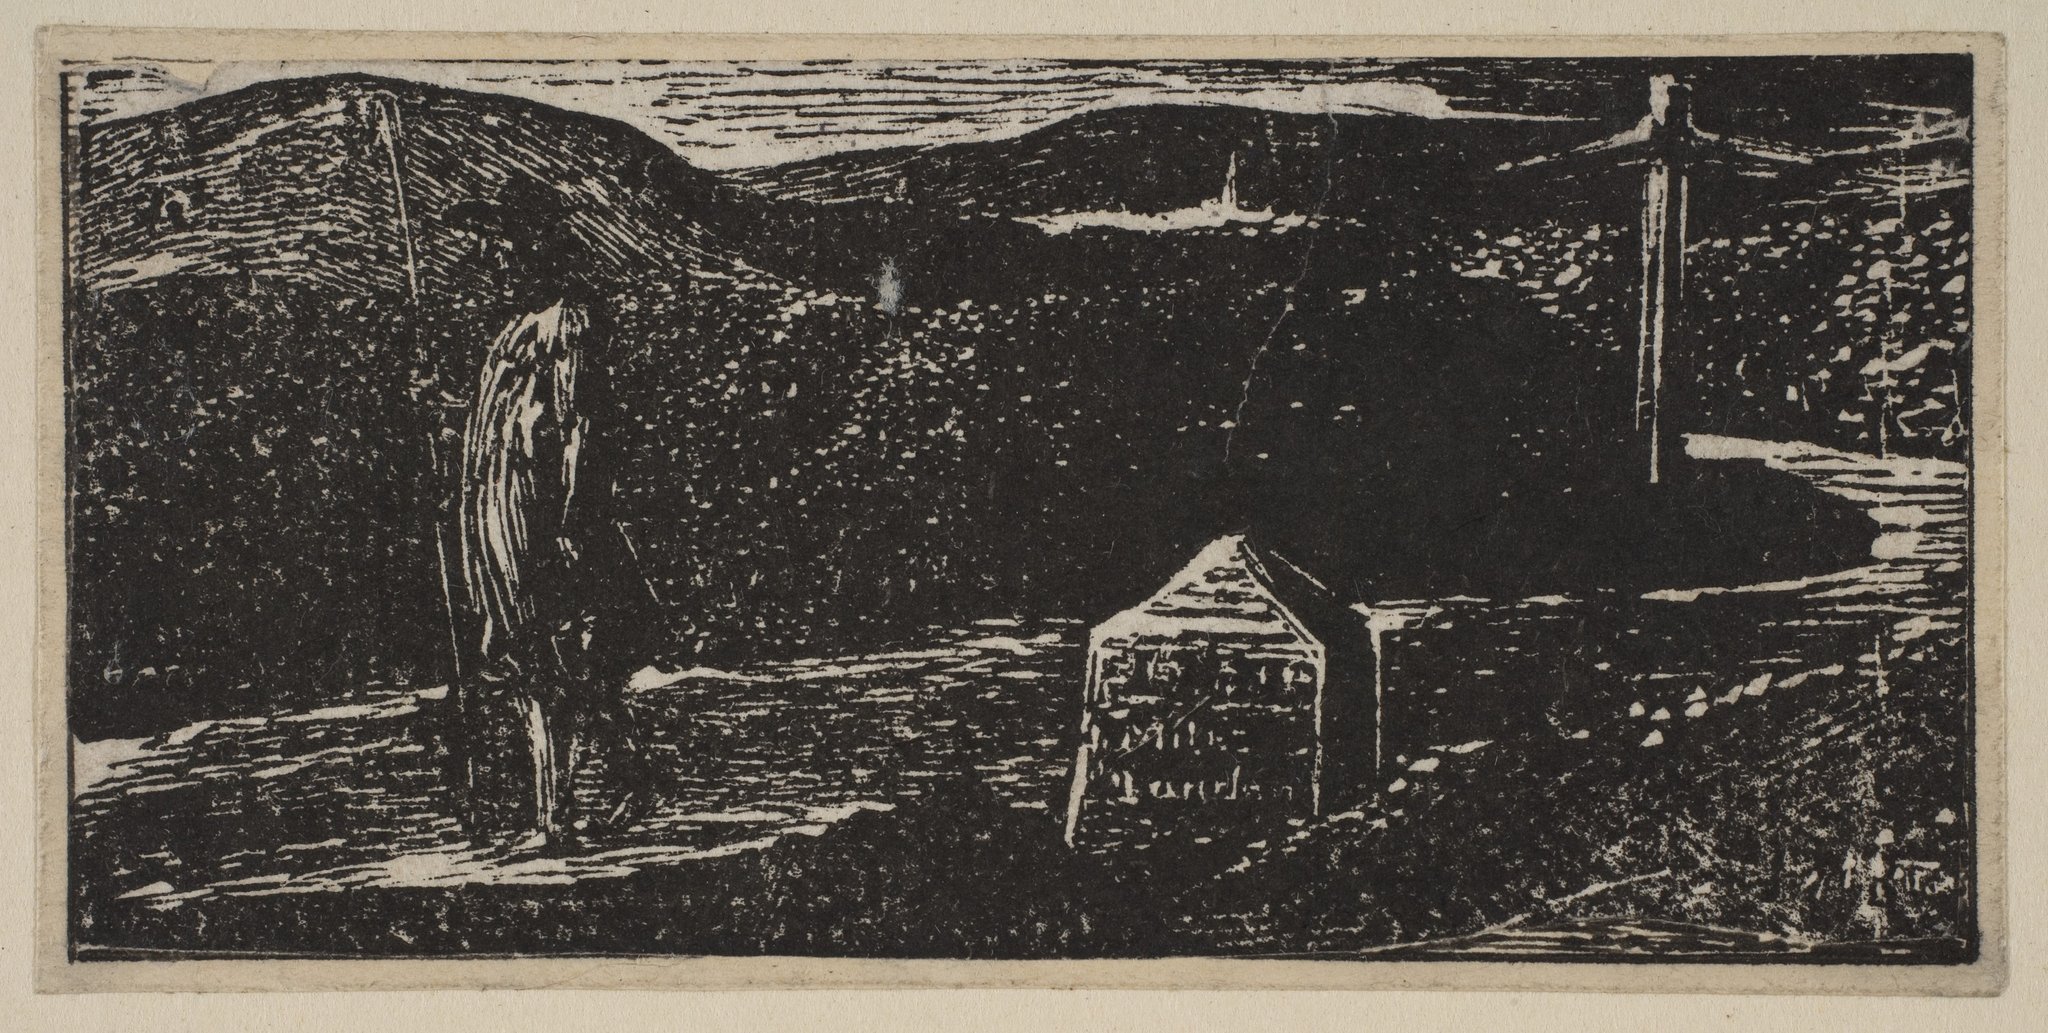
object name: print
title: Colinet's Journey: Milestone Marked 'LXII Miles to London', from Thornton's "Pastorals of Virgil"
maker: william blake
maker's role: artist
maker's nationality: british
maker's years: 1757-1827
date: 1821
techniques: engraving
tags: roads,men